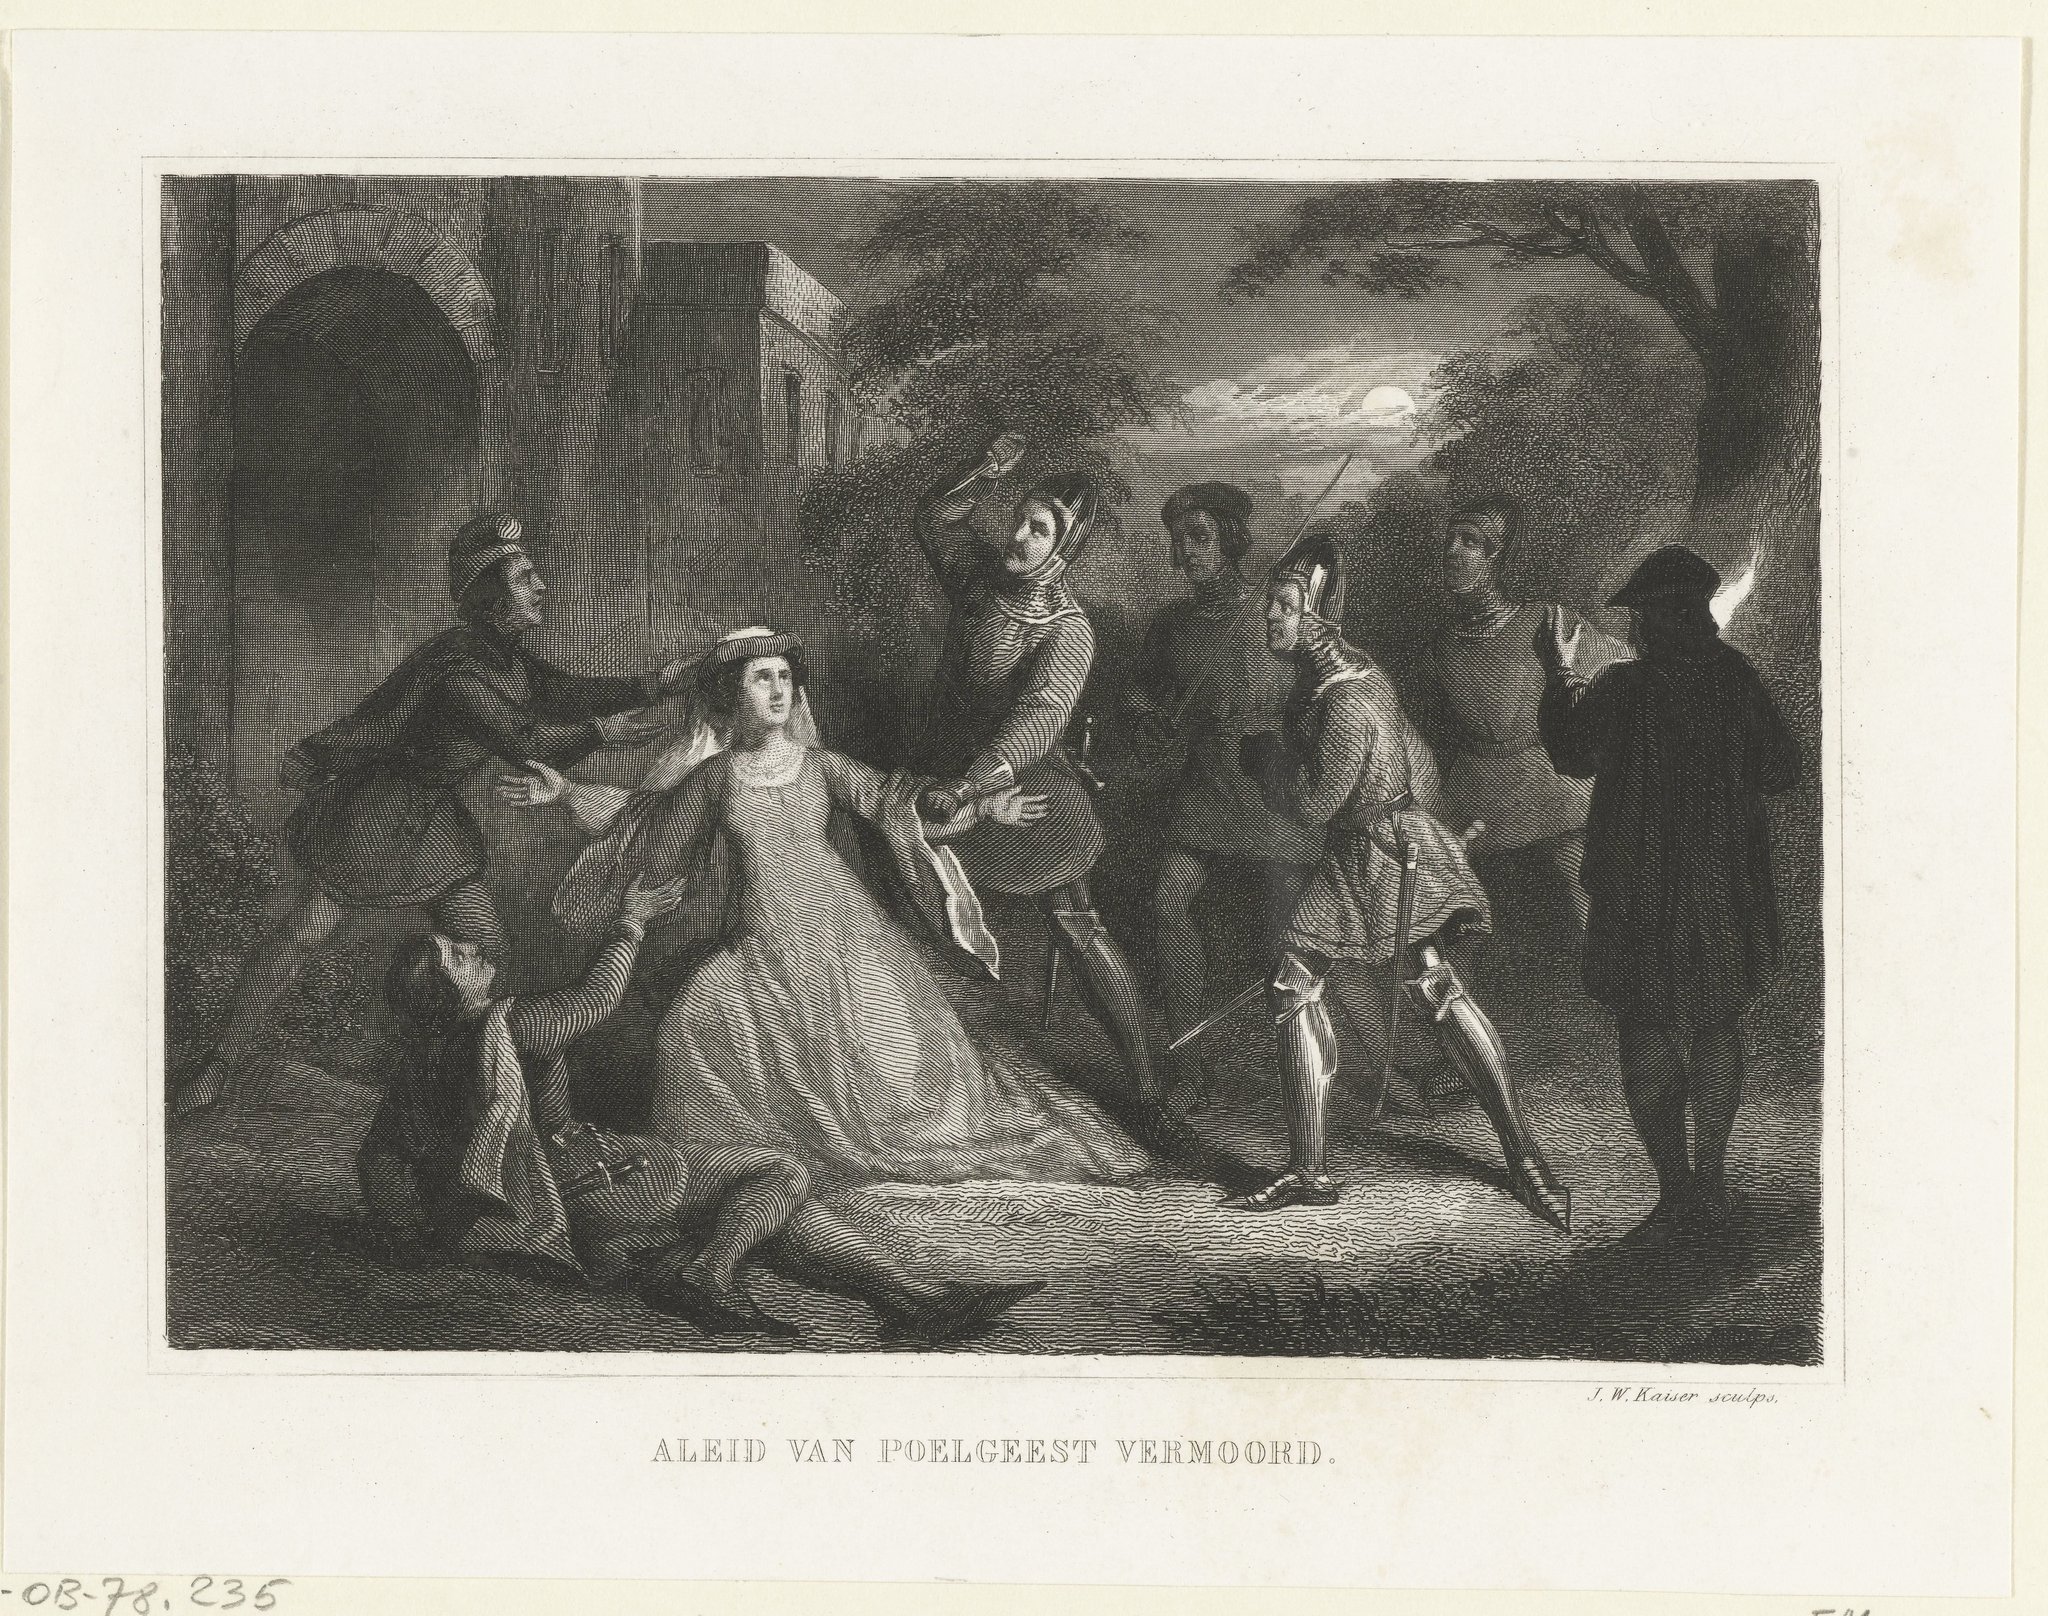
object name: print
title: Aleid van Poelgeest vermoord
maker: johann wilhelm kaiser (i)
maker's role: draughtsman, print maker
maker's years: 1813-1900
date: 1842-1844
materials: paper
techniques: engraving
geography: netherlands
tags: the hague, duke of bavaria albert i, violent death, being killed; being mishandled and maltreated; seeking death, netherlands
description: Illustratie voor: J.P. Arend, Algemeene geschiedenis des vaderlands, Amsterdam, 5 delen, 1840-1882, dl. 2.2 (1844), p. 300.